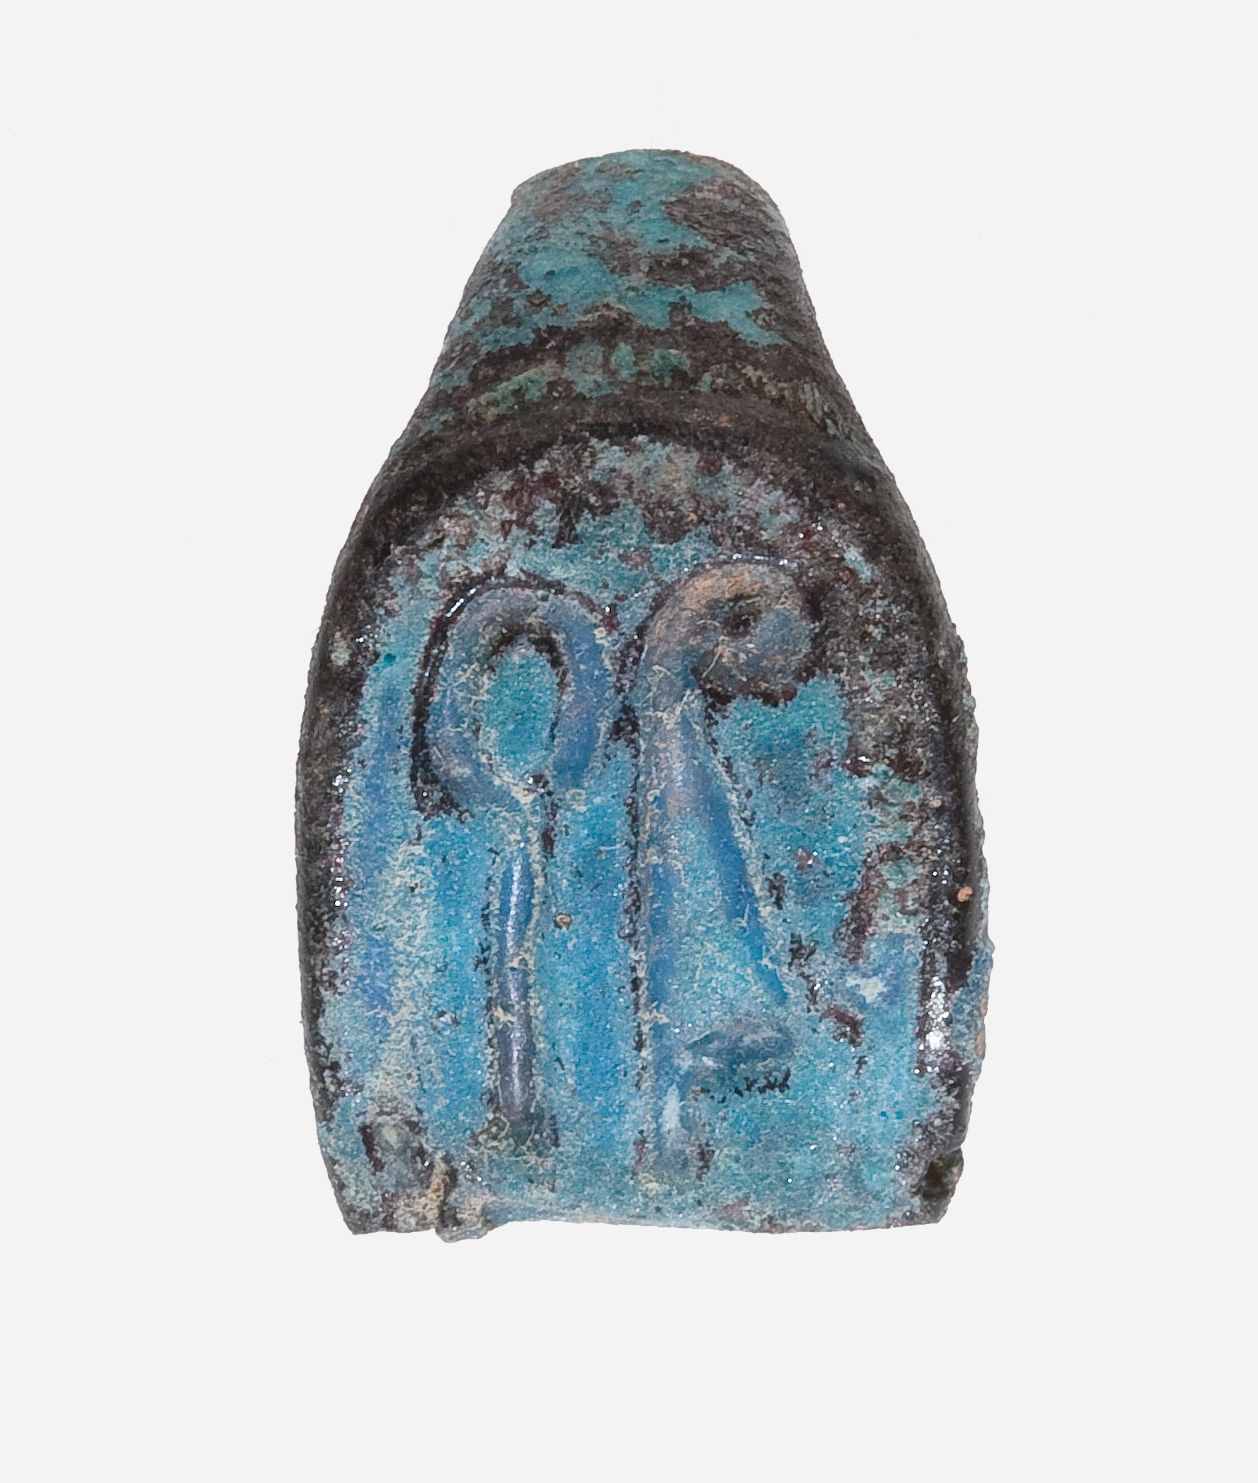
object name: ring fragment, maat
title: Ring Fragment, heqa maat device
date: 1390-1352 BCE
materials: faience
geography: egypt